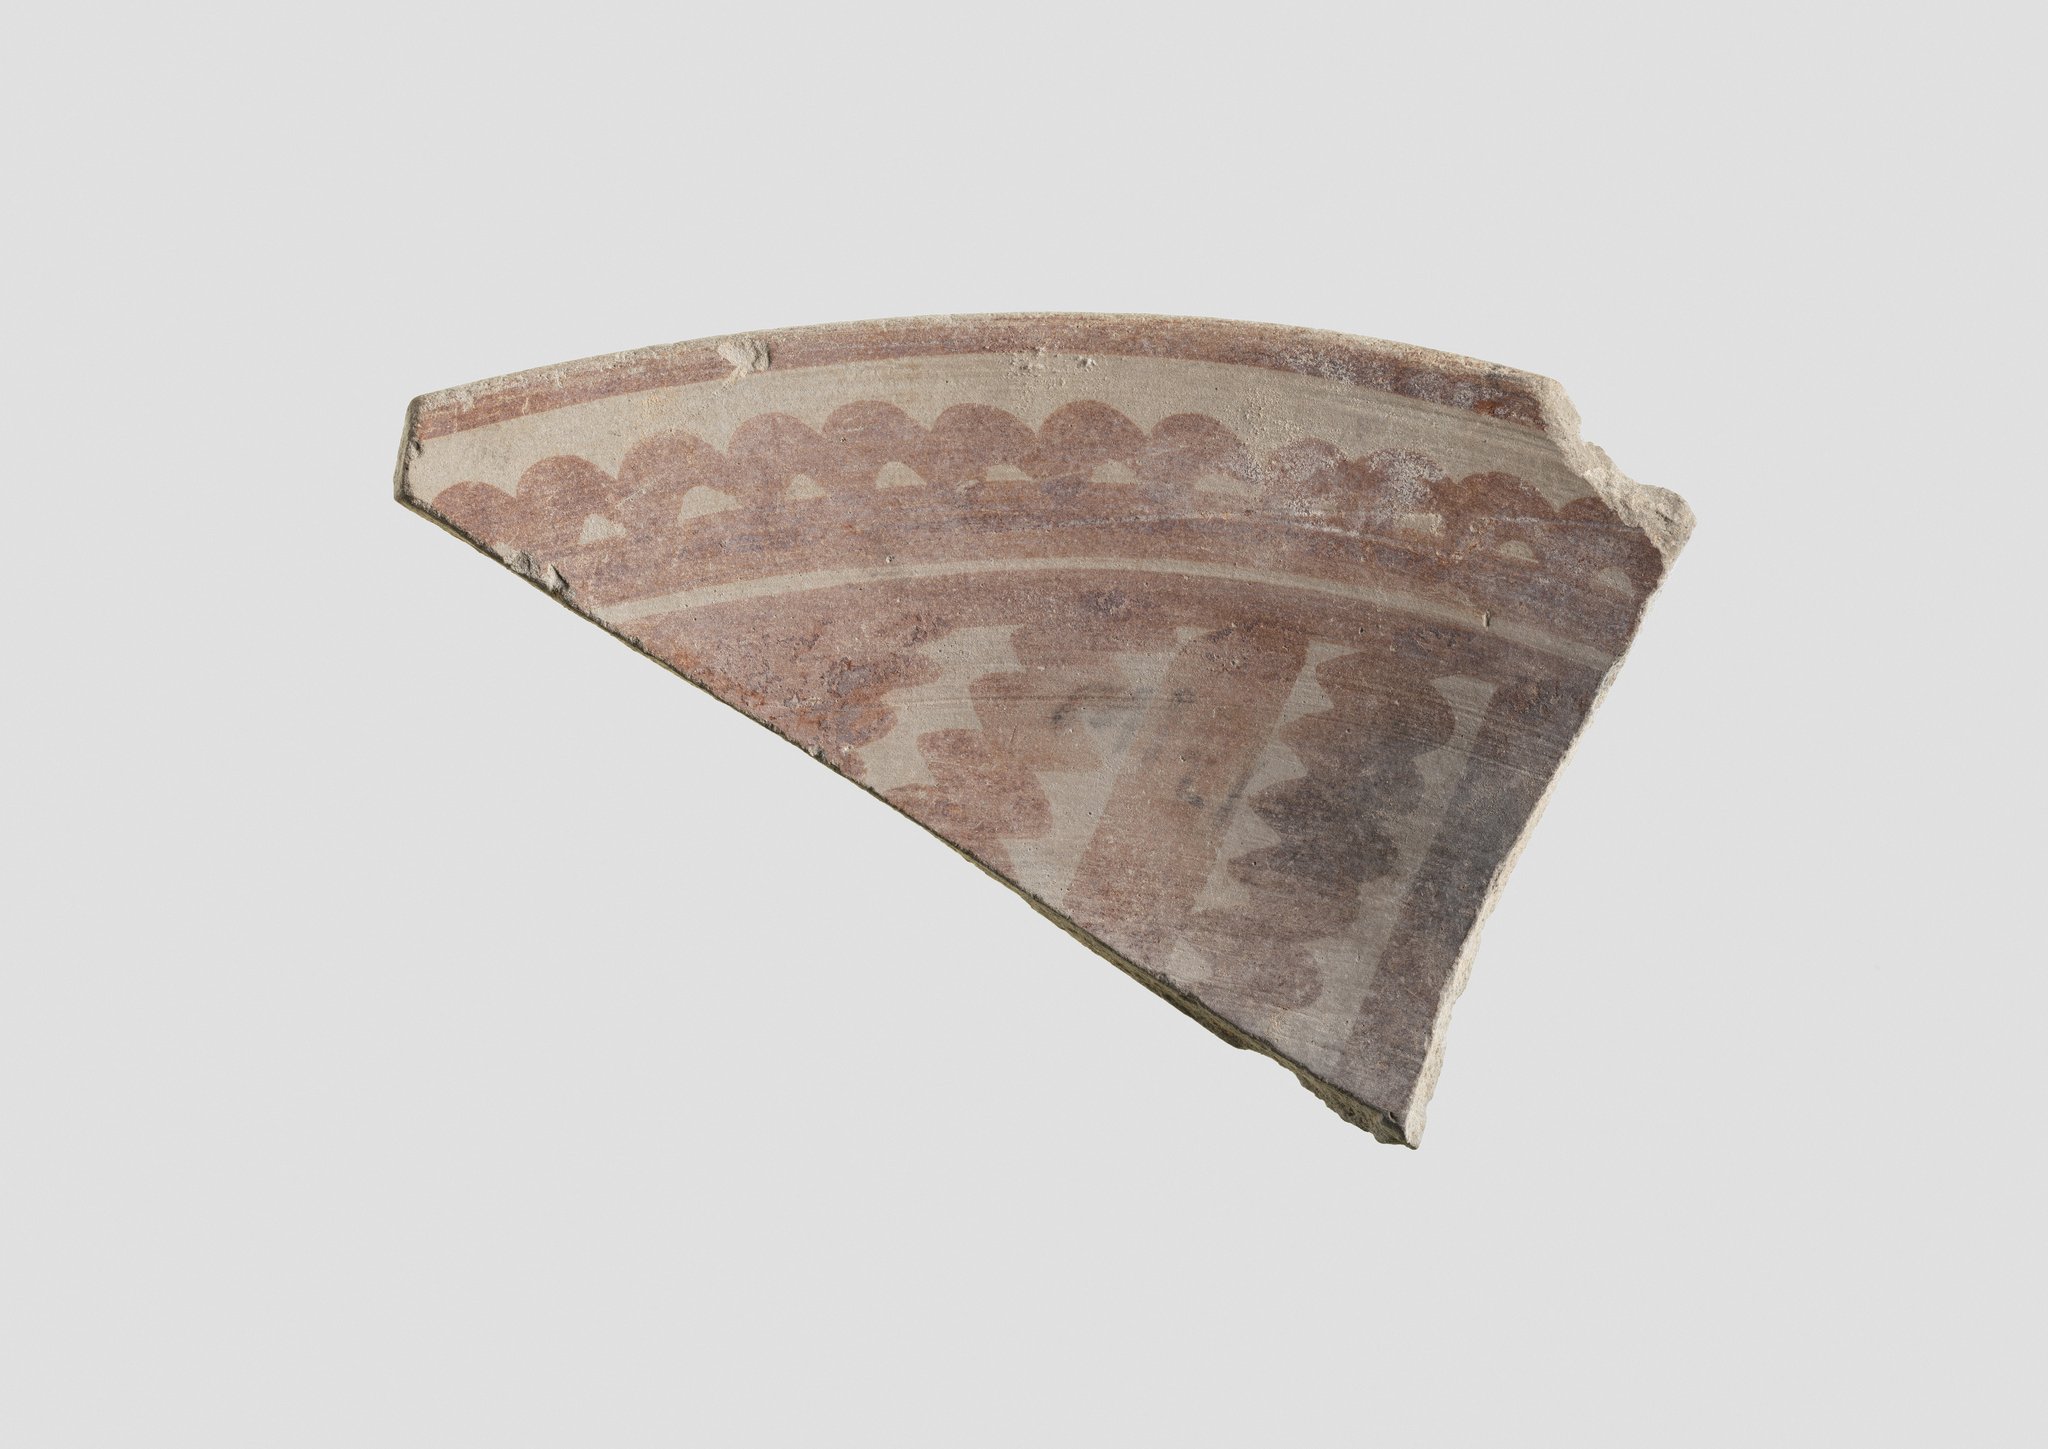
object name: sherd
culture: indus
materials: ceramic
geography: indus region